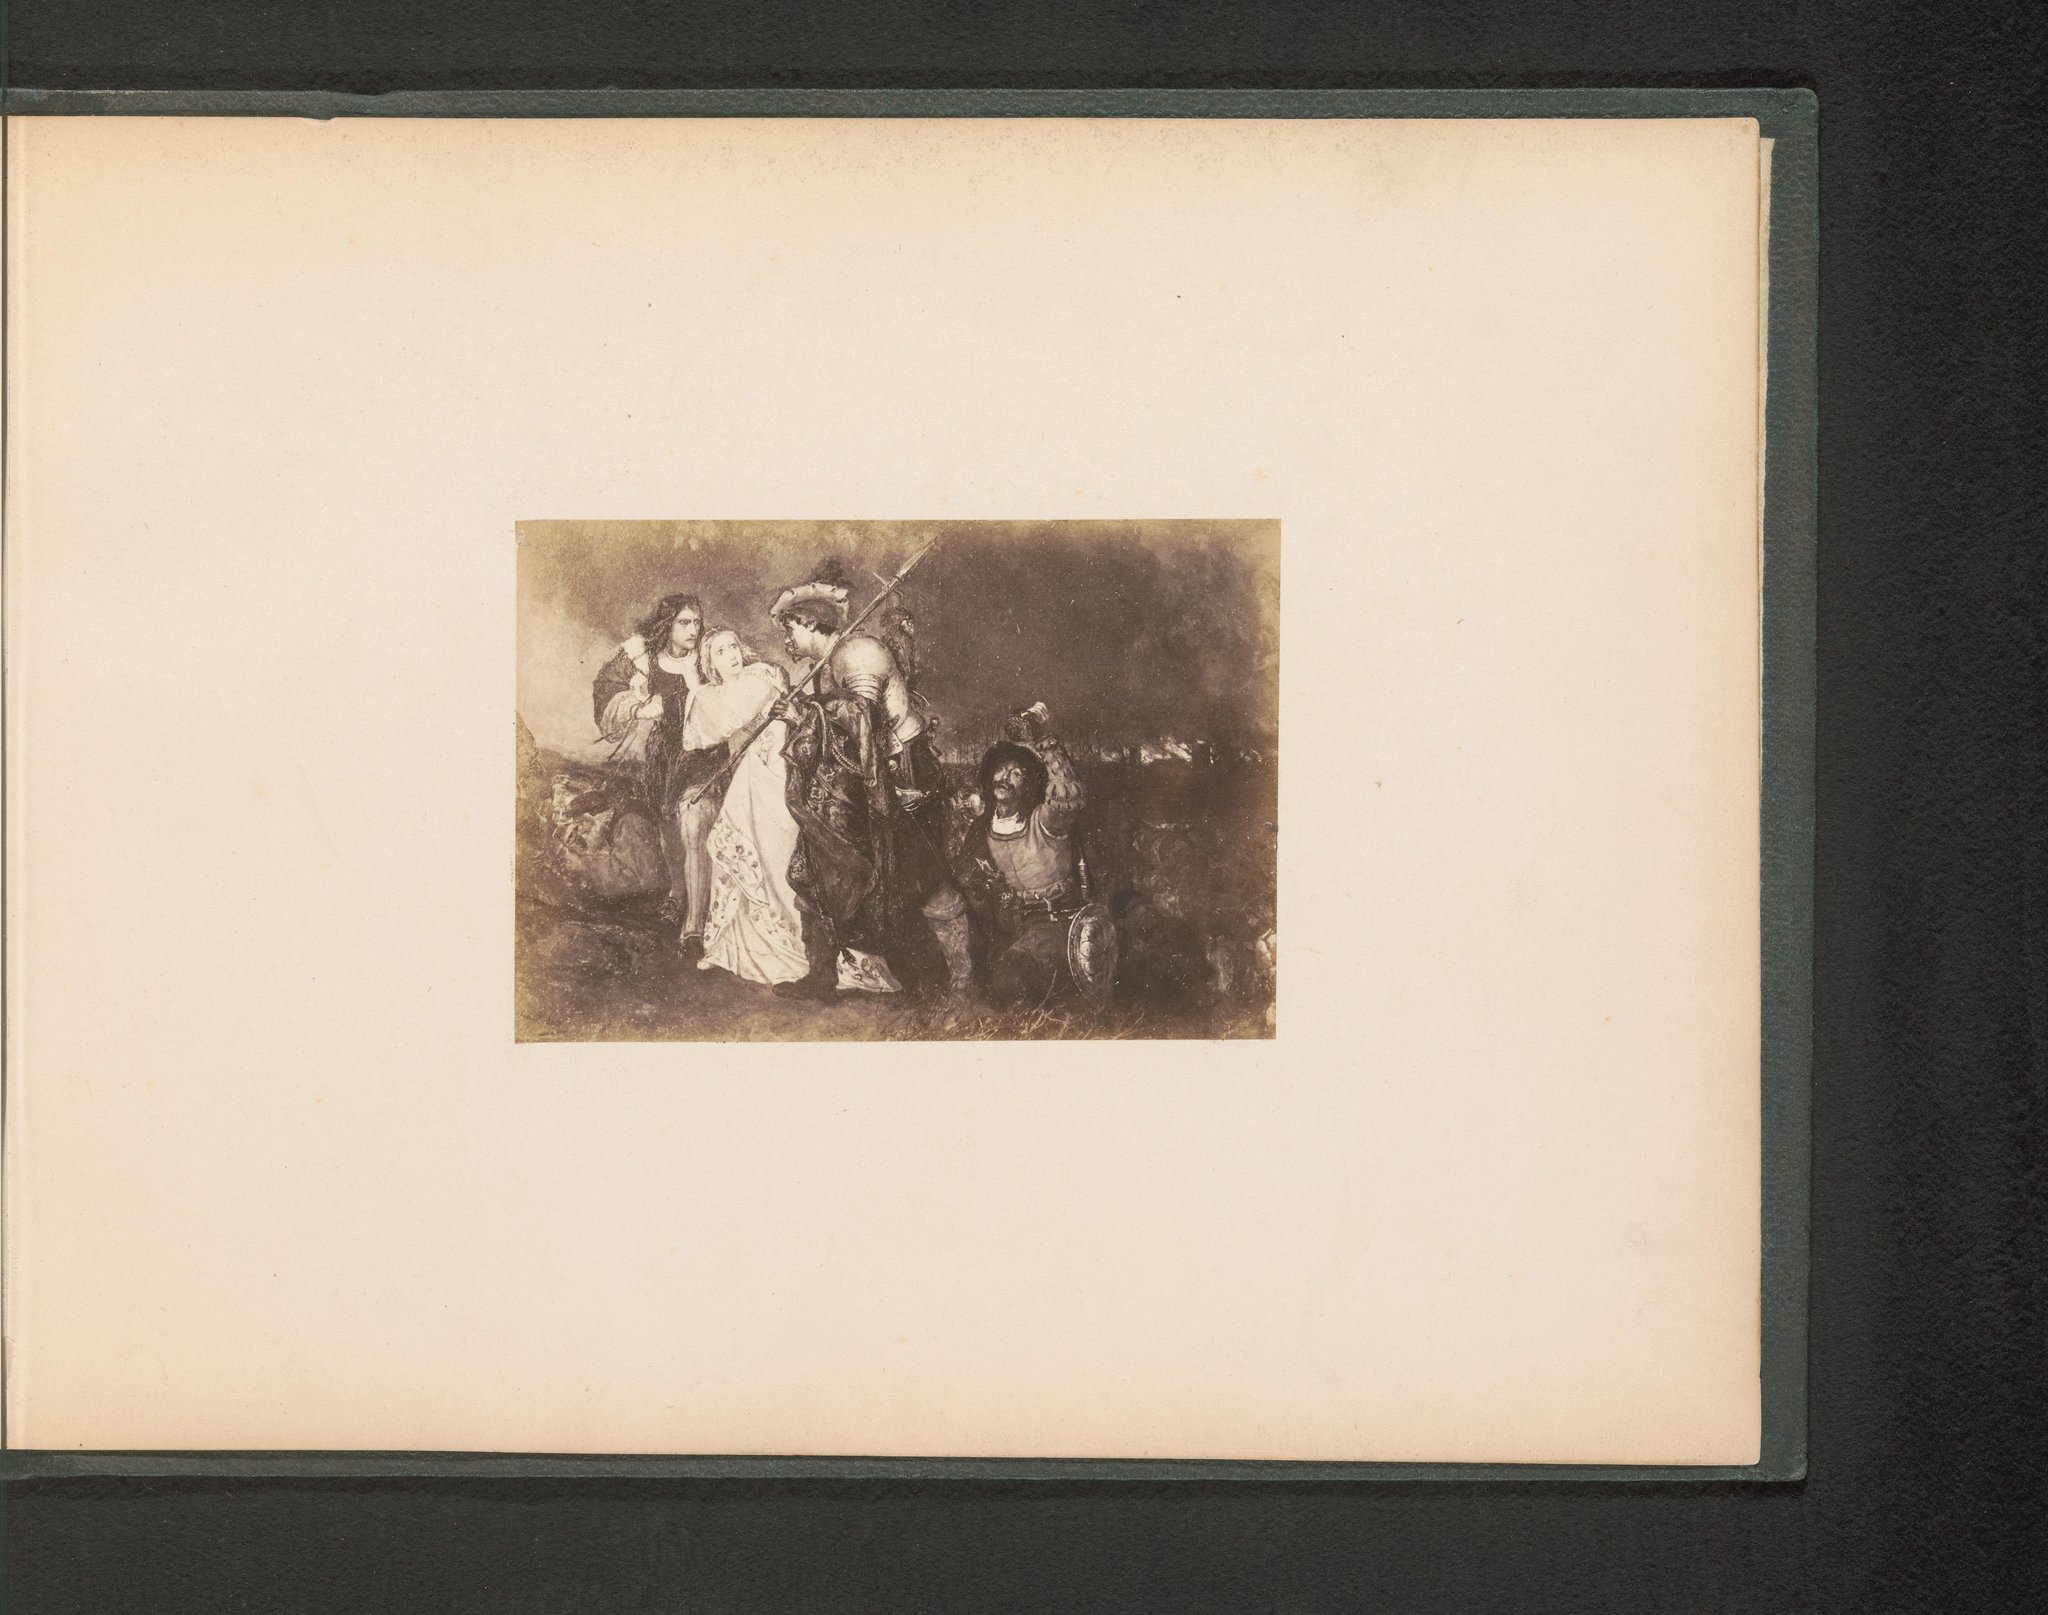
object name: page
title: Fotoreproductie van La Guerre van Joseph Lies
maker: Anonymous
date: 1858-1863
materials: photographic support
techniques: albumen print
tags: historical persons, casting weapons: spear, picture, painting